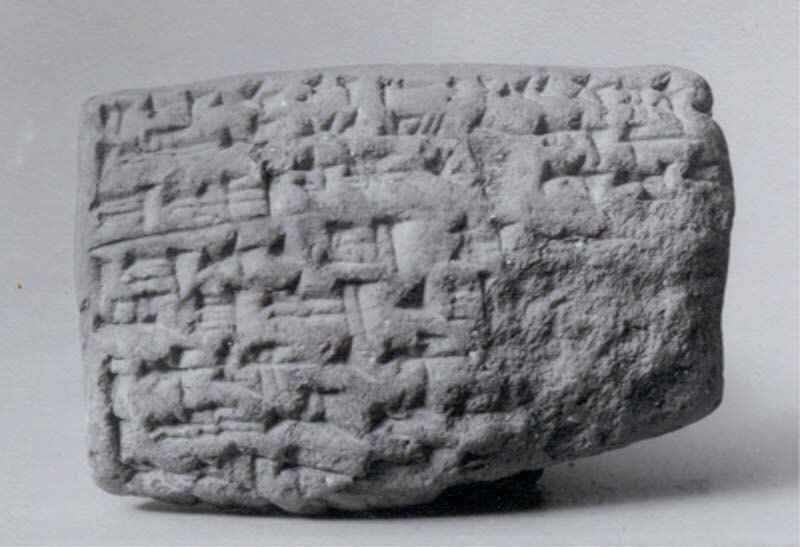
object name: cuneiform tablet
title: Cuneiform tablet: account of receipt of apparel for divinities, Ebabbar archive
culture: babylonian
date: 605-562 BCE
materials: clay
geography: mesopotamia